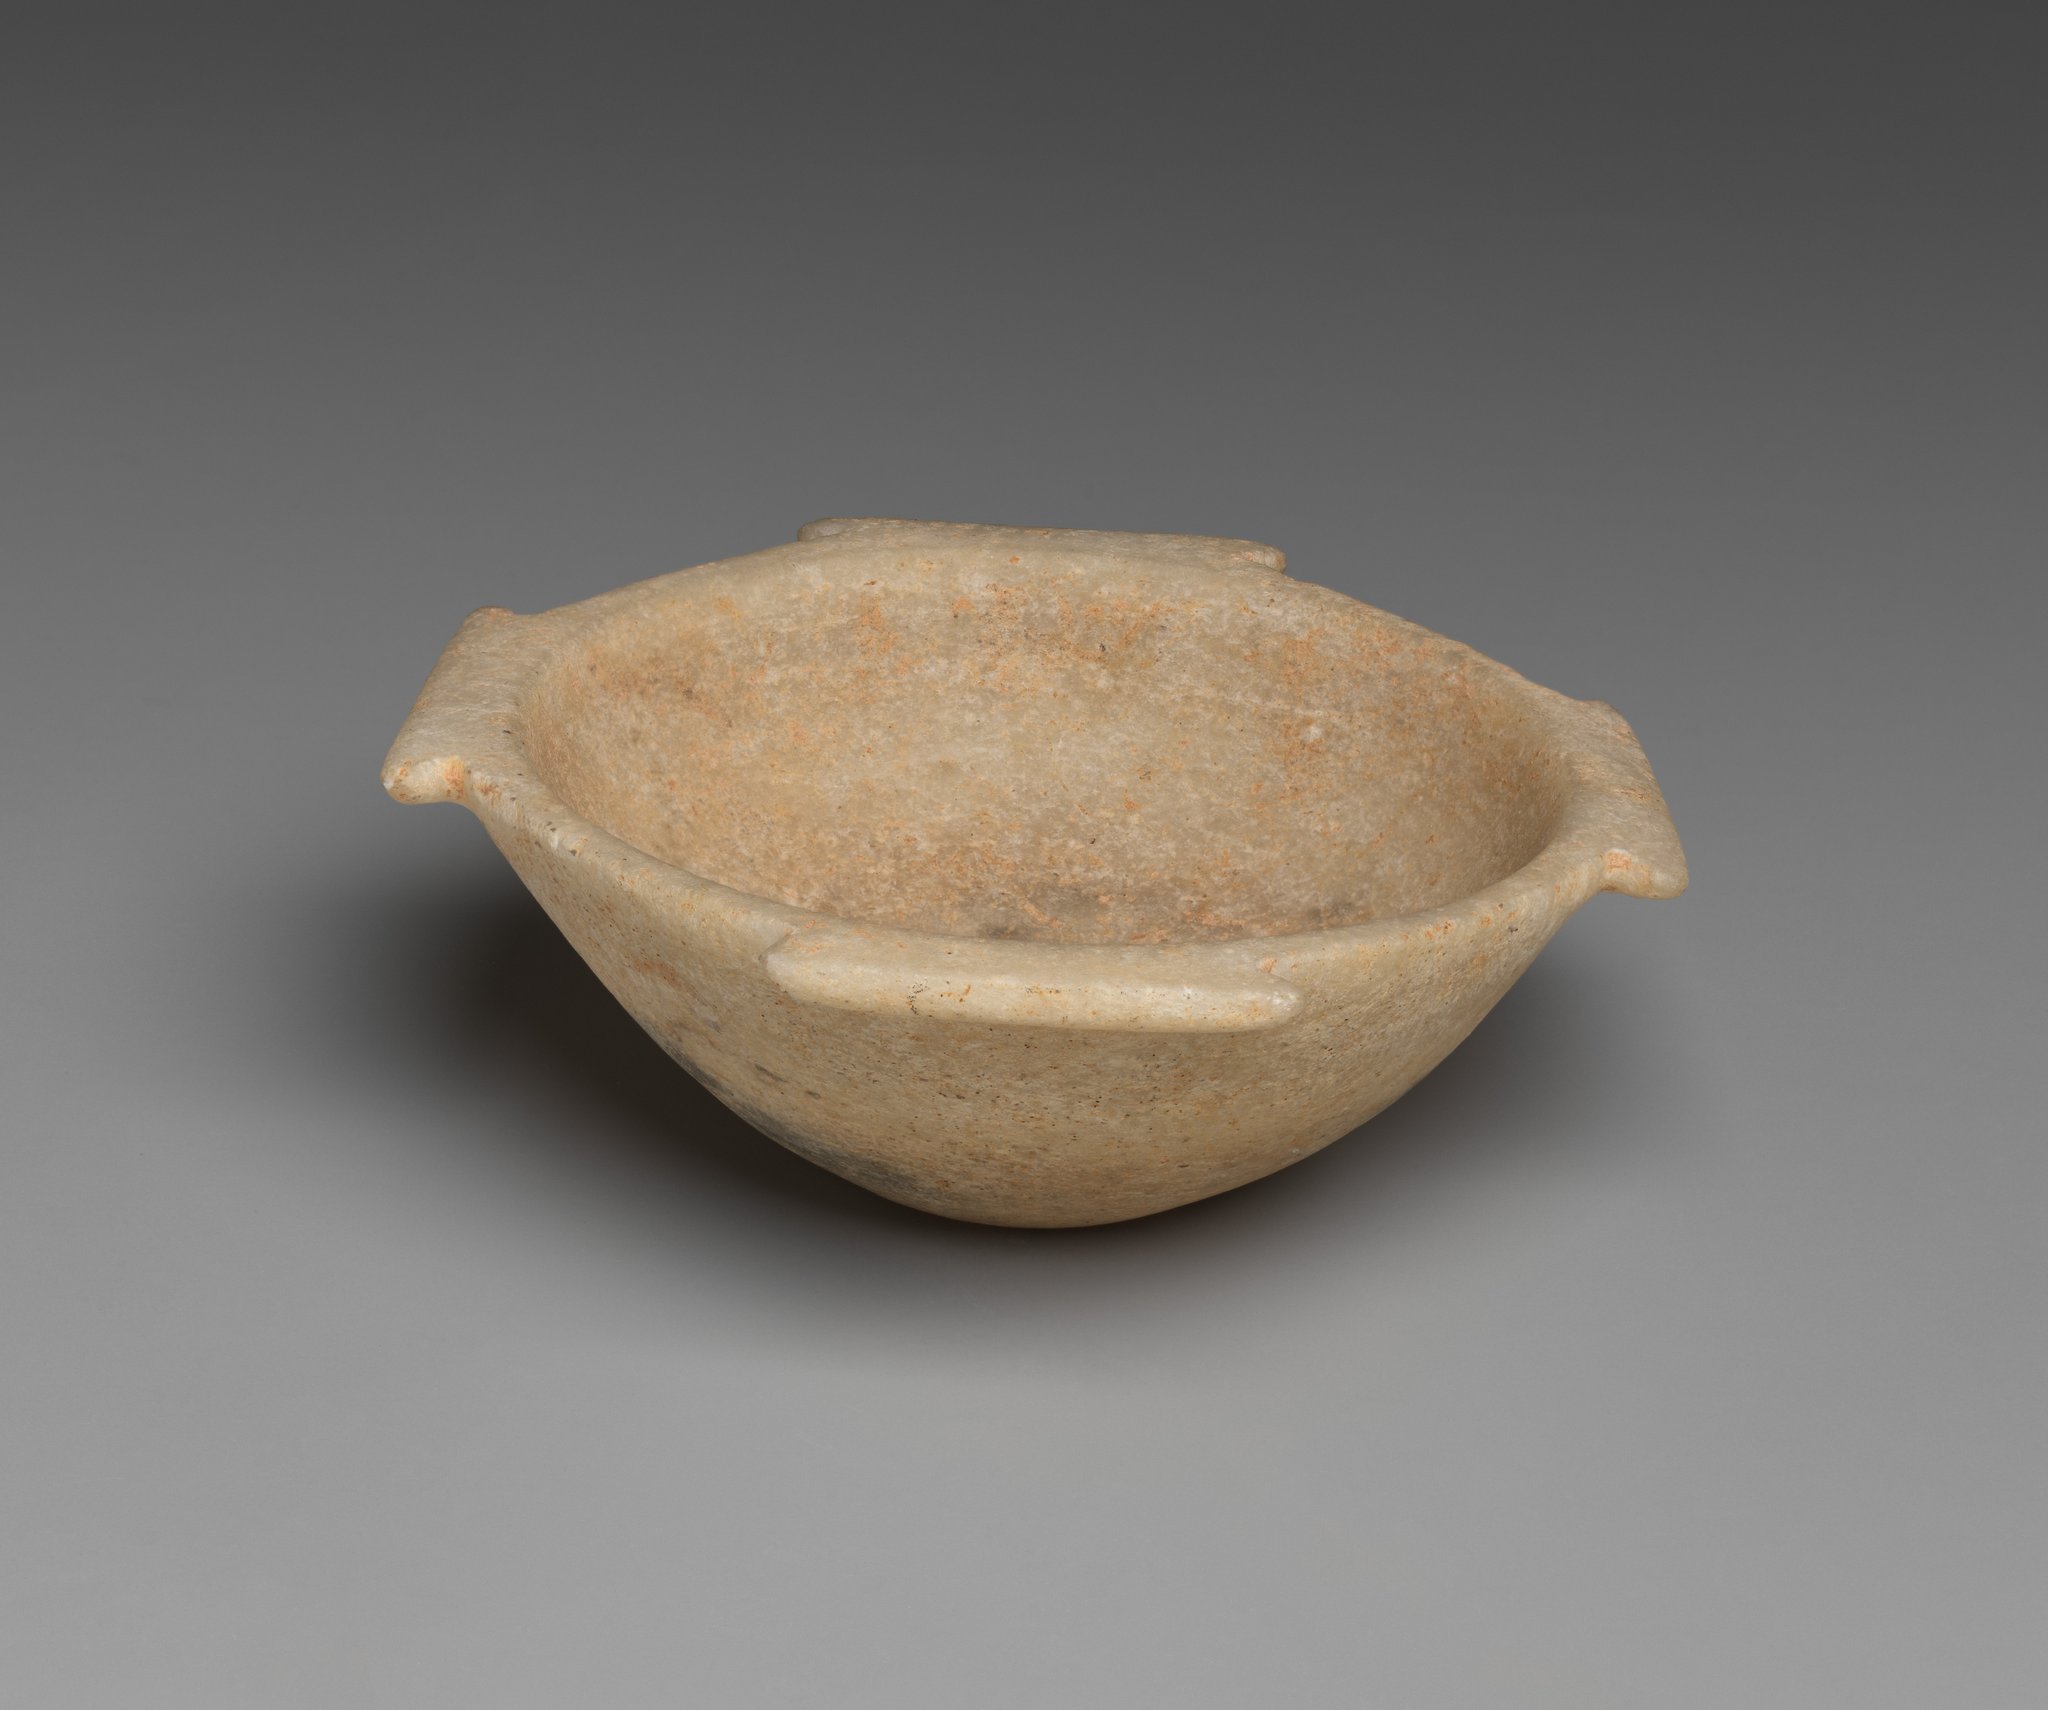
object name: bowl with four flange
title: Marble bowl with four flanges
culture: cycladic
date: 2700-2200 BCE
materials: marble